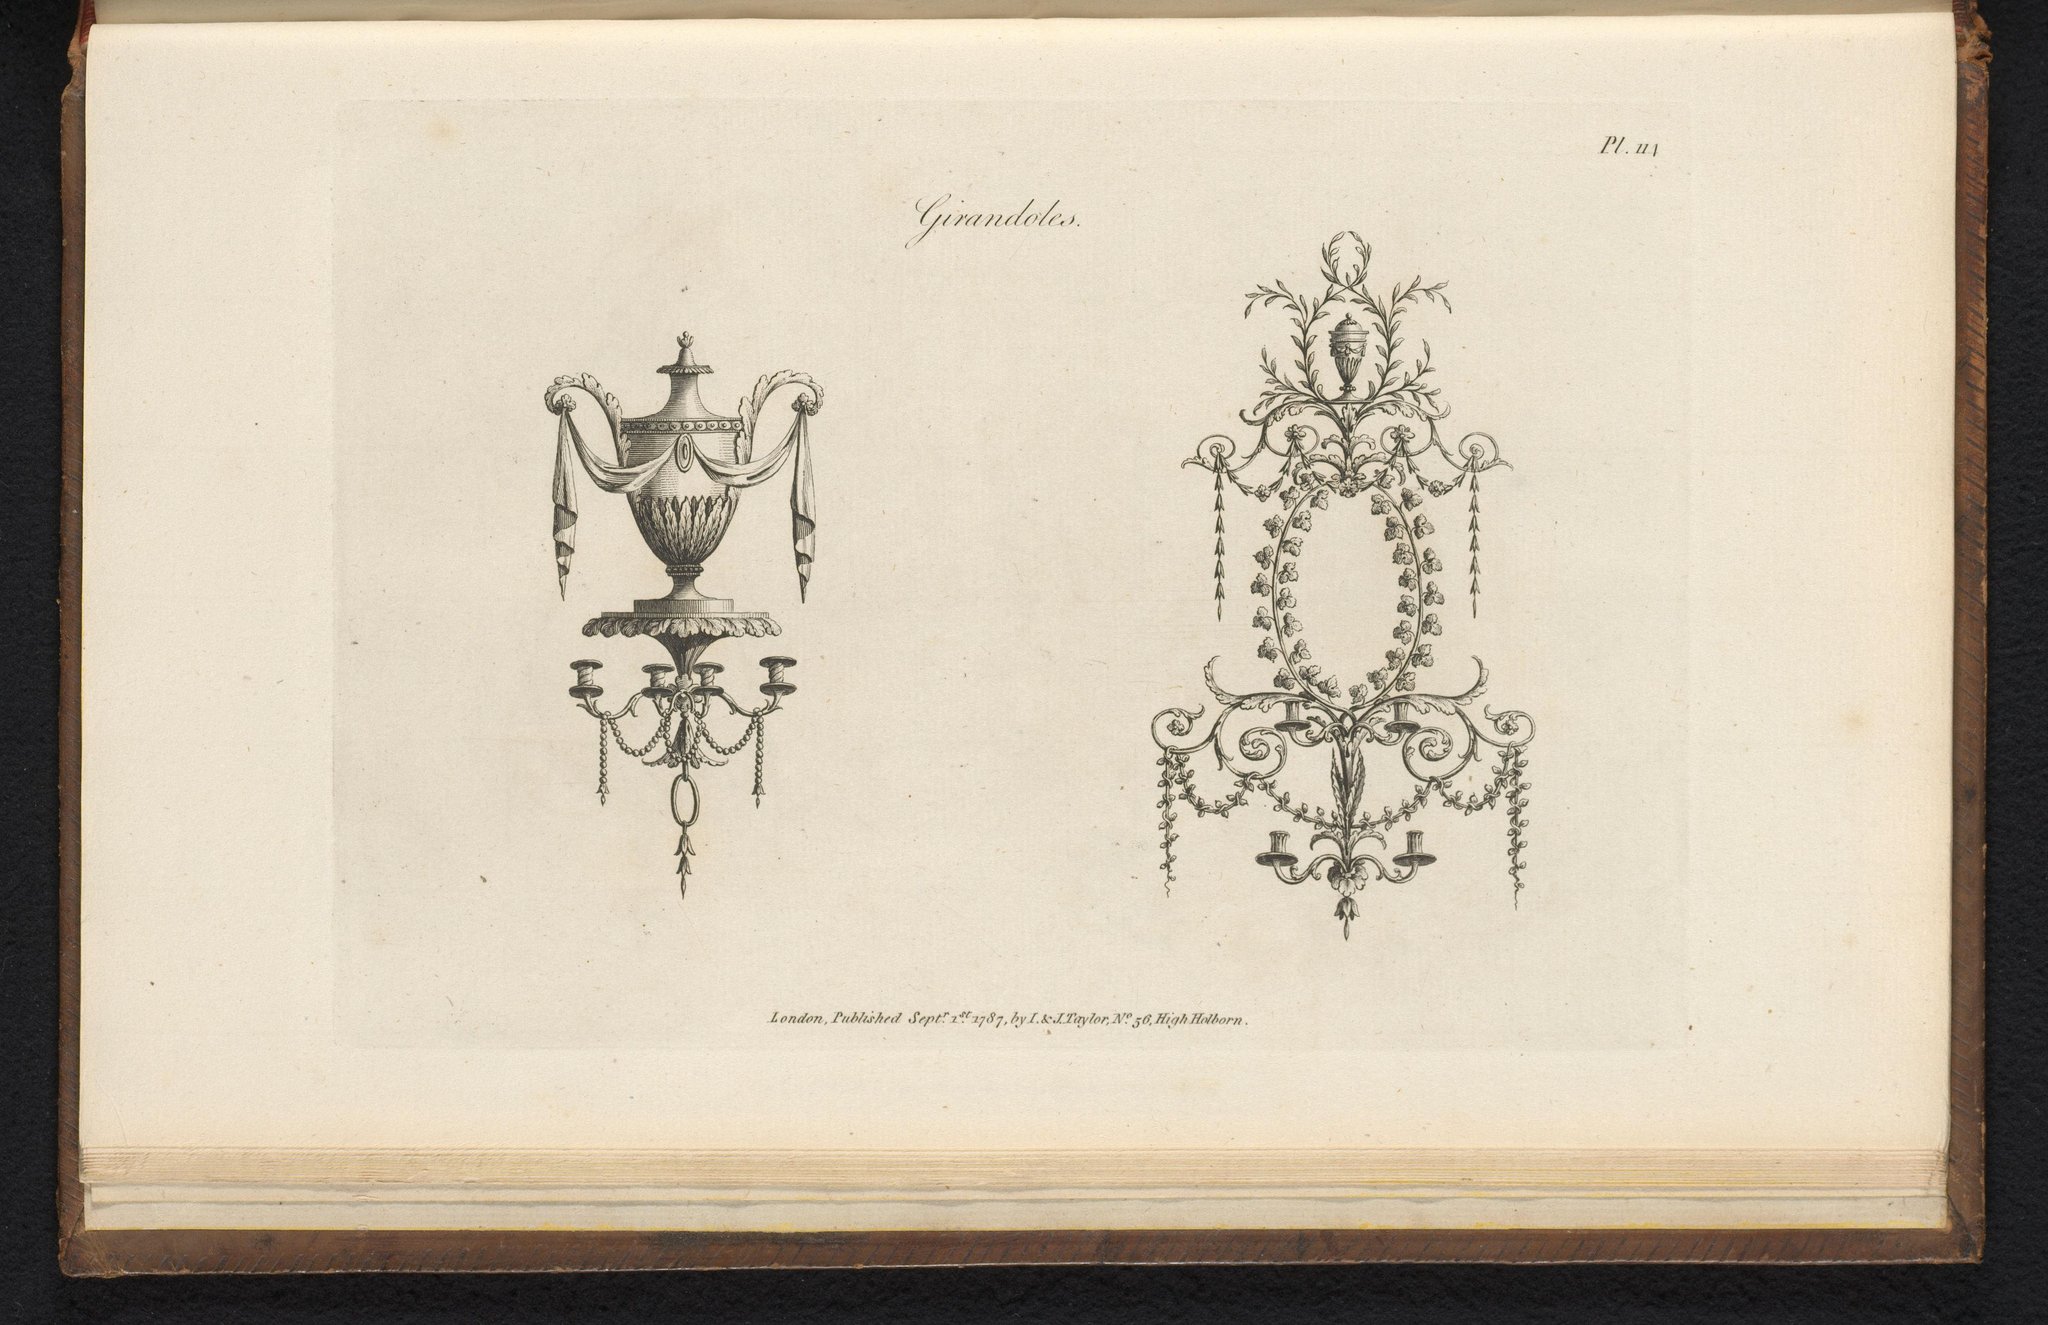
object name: page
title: Girandoles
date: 1787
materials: paper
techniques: engraving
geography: holborn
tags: chandelier, candelabrum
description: Genummerd: Pl. 114. Prent maakt deel uit van een boek.